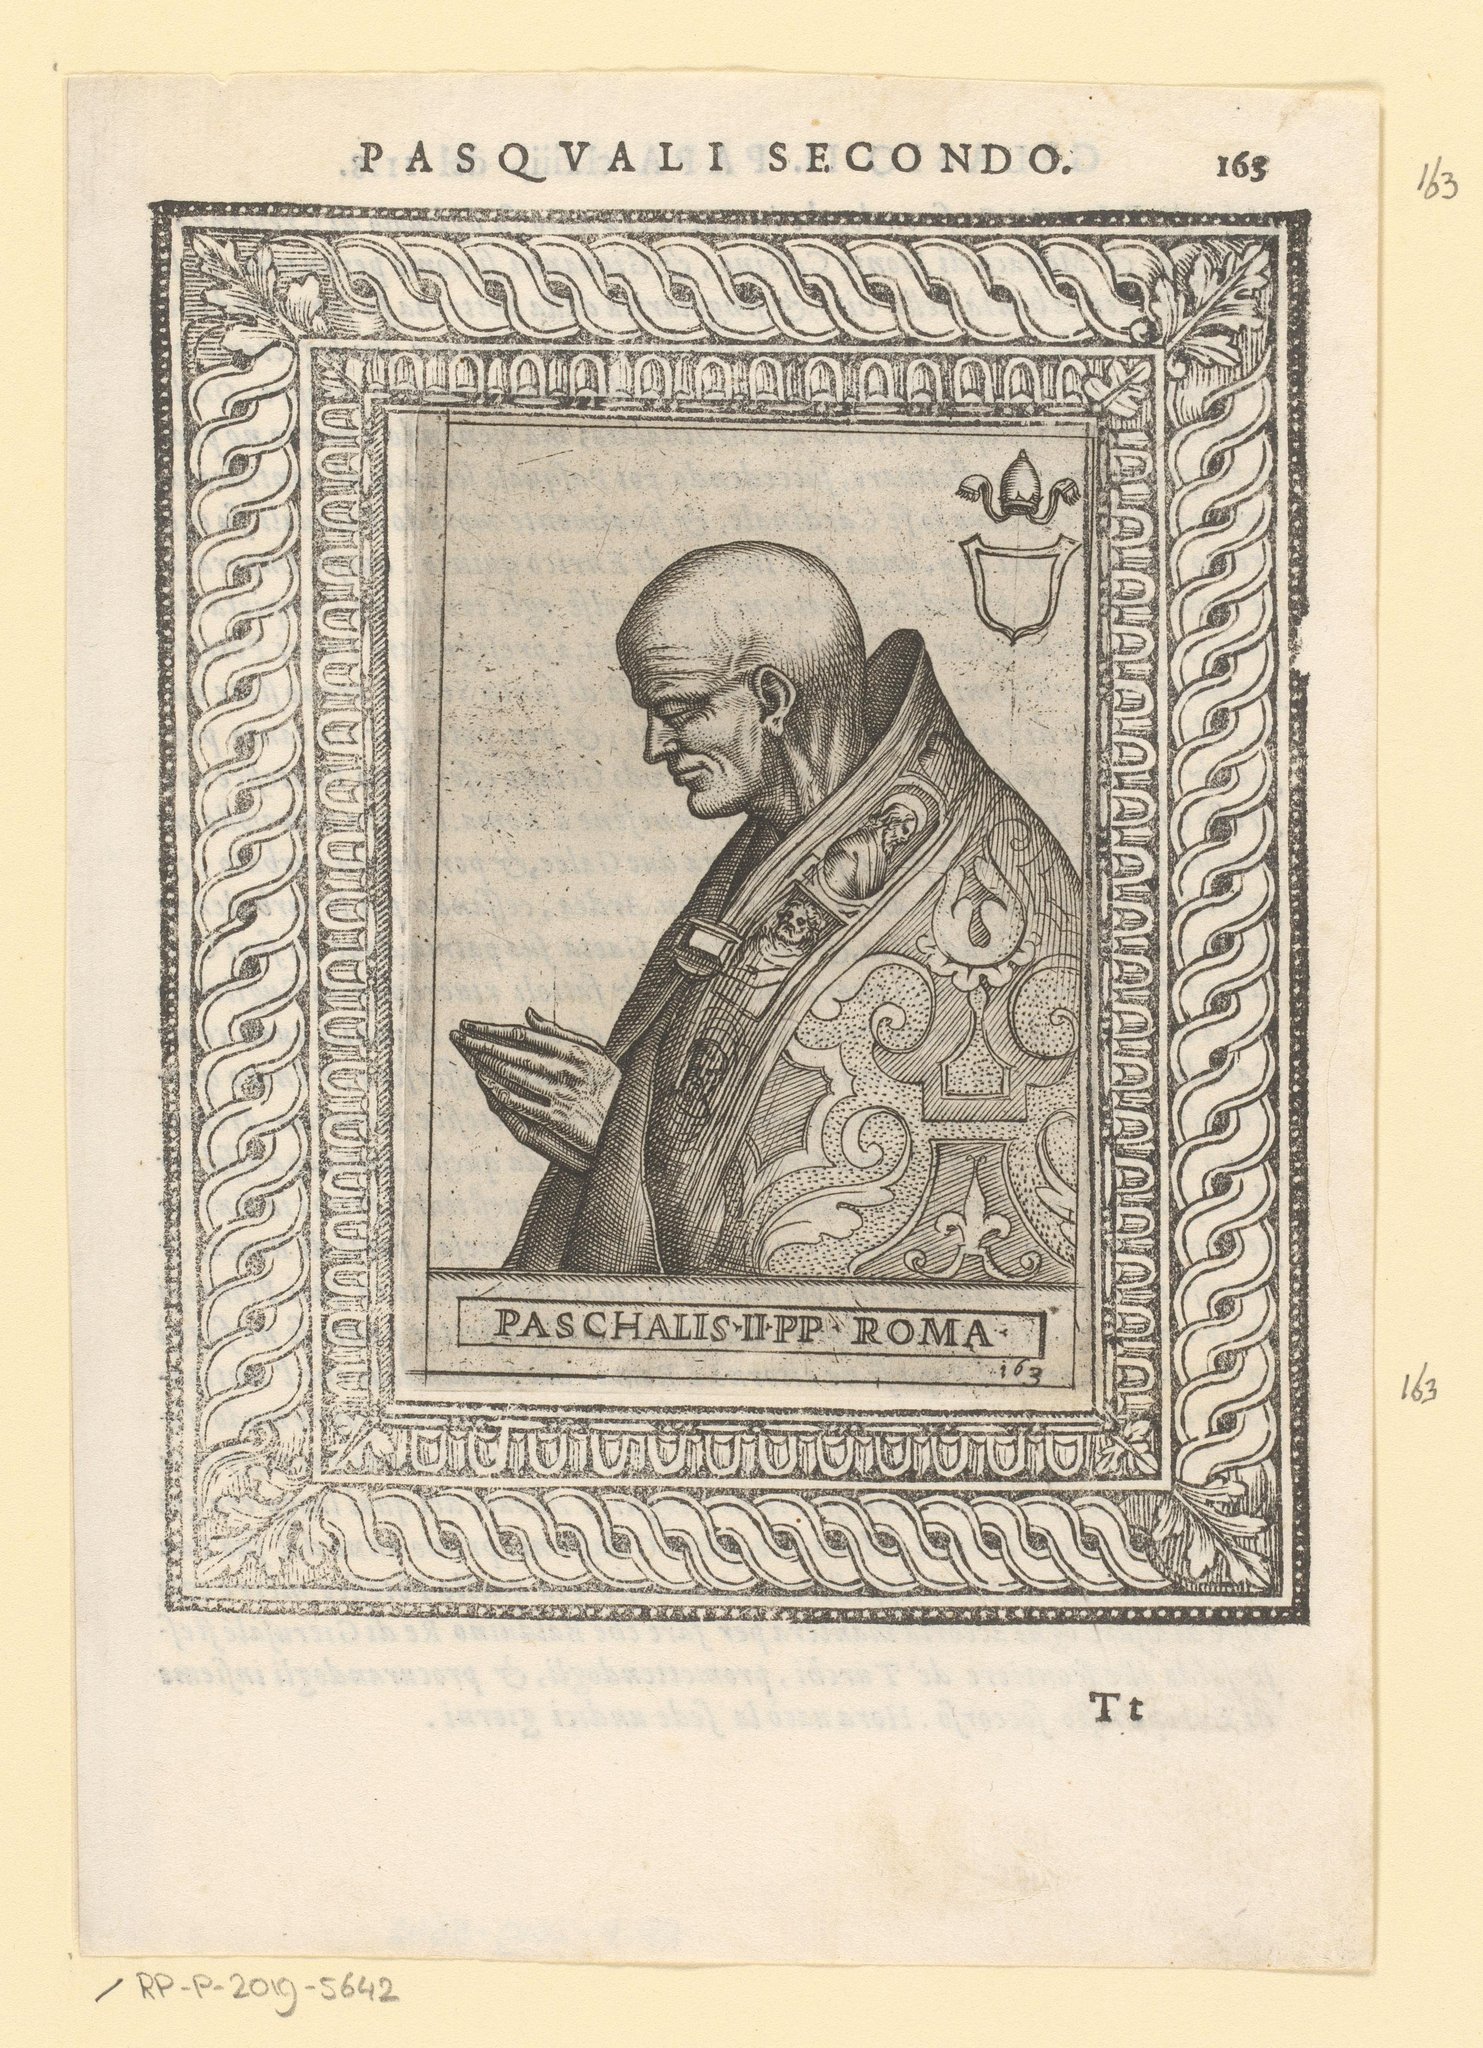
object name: print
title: Paschalis II PP Roma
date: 1587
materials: paper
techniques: engraving, letterpress printing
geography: rome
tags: historical persons, pope, armorial bearing, heraldry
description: Prent uit: Ciccarelli, Antonio. Le vite de Pontefici di Antonio Ciccarelli (...). Rome: Domenico Basa, 1587. Prent voor het eerst verschenen in: Cavalieri, Giovanni Battista de'. Pontificum romanorum effigies (...). Rome: Domenico Basa en Francesco Zanetti, 1580. Prent ook gebruikt in latere publicaties.